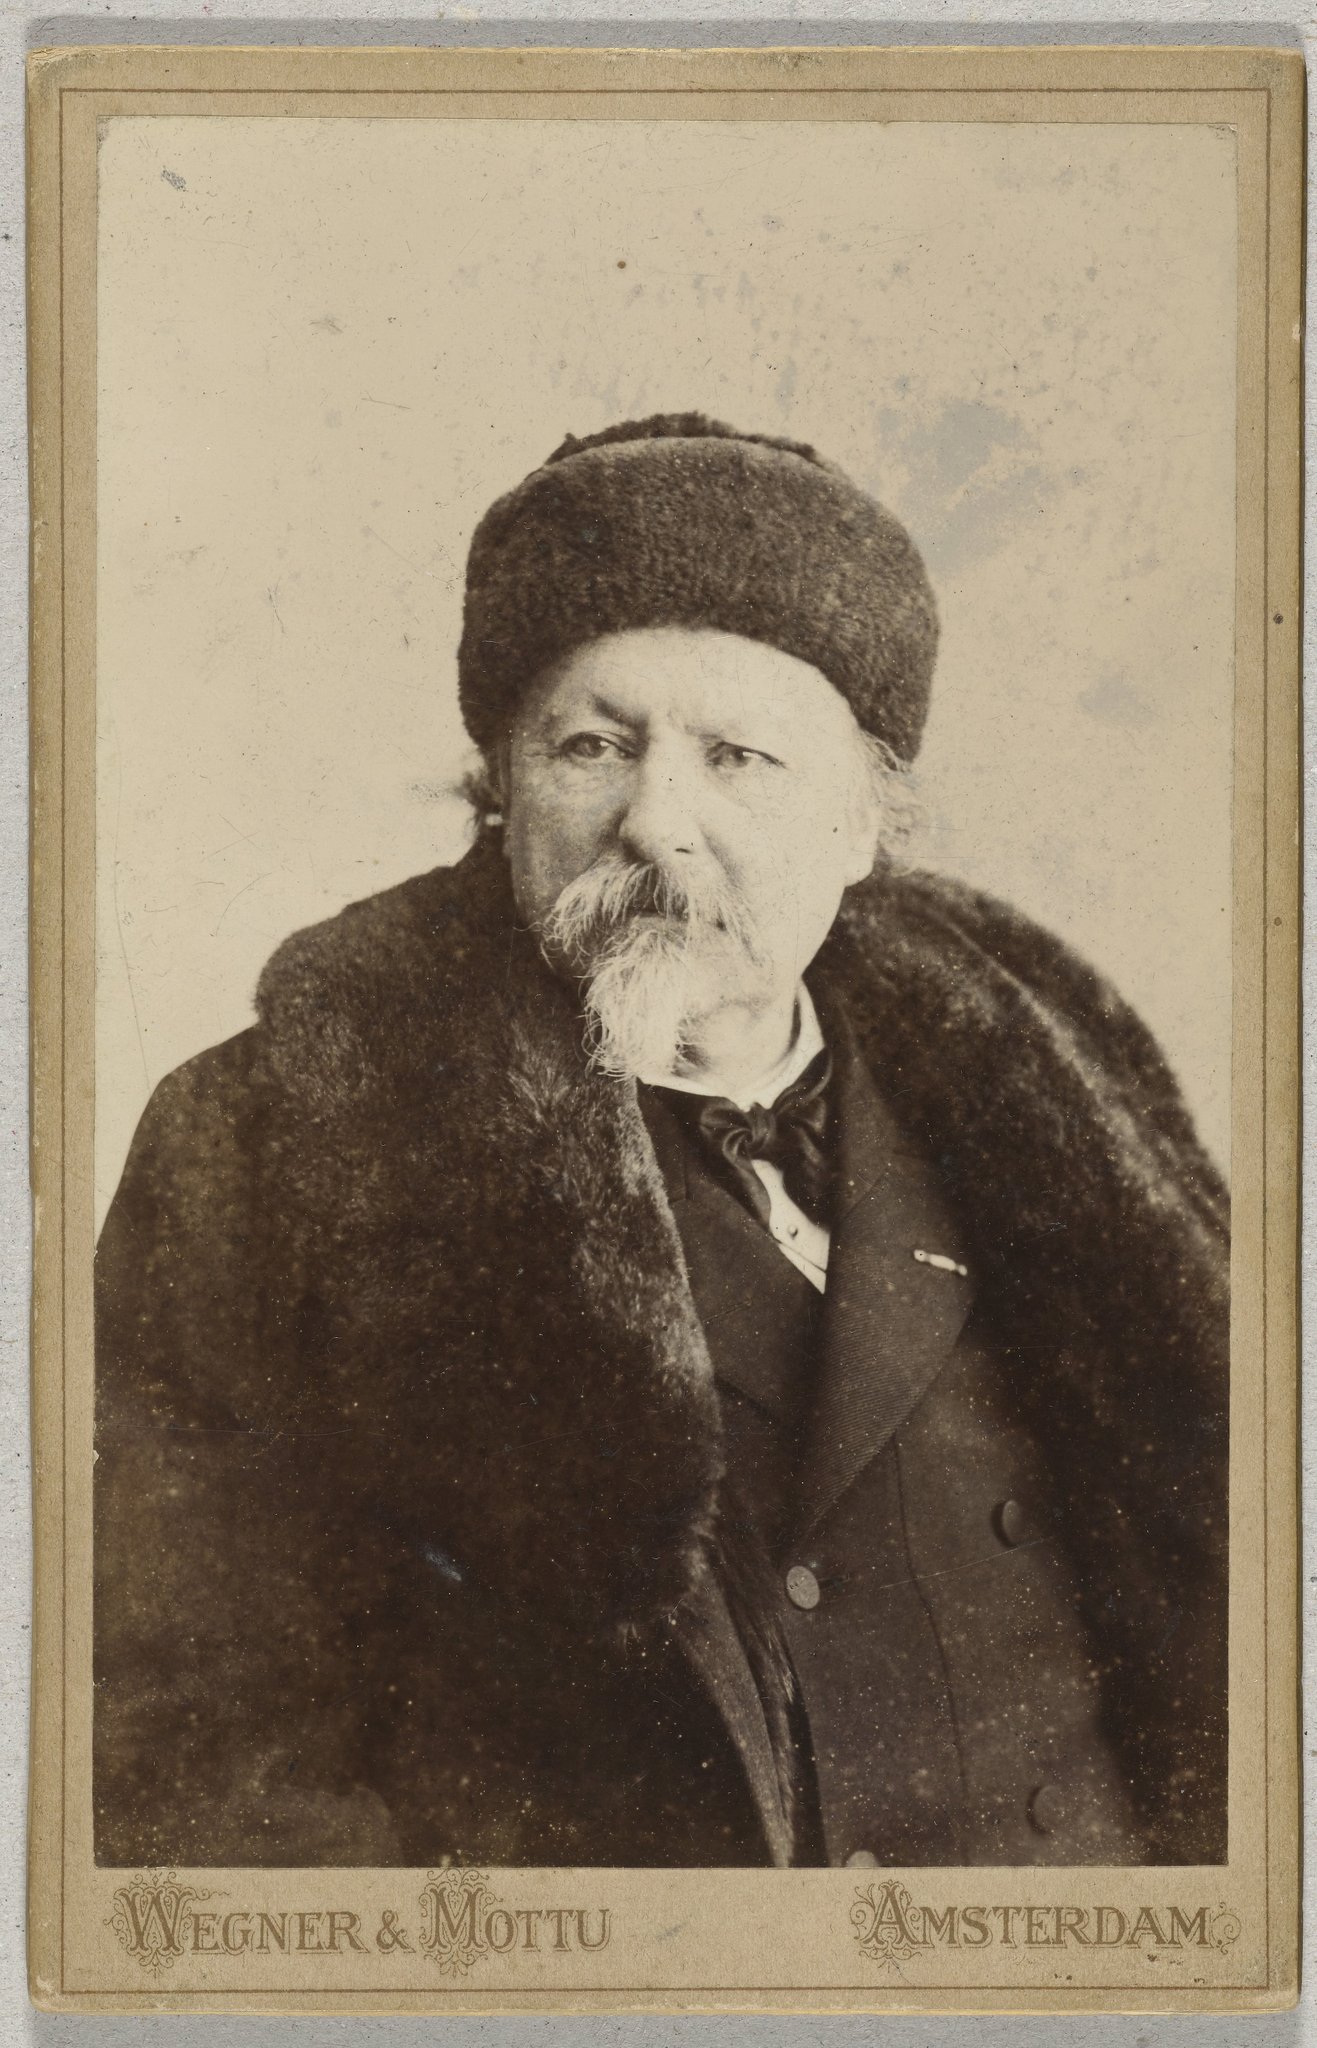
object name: cabinet photograph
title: Portret van Johan Philip van der Kellen (1831-1906), directeur van het Rijksprentenkabinet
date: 1890-1906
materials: paper, cardboard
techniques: gelatin silver print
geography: amsterdam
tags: draughtsman, johan philip van der kellen, historical persons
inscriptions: inscription: ‘Johan Philip van der Kellen / (Ridder Nederl. Leeuw) / 2e stempelsn.; later / Dir. Prentenkabinet’, inscription: ‘WEGNER & MOTTU AMSTERDAM’, inscription: ‘Photographisch Artistisch Atelier/ van/ Wegner & Mottu/ Rokin over de Bank 138,/ Amsterdam/ Het cliché wordt voor verdere/ bestellingen bewaard.’